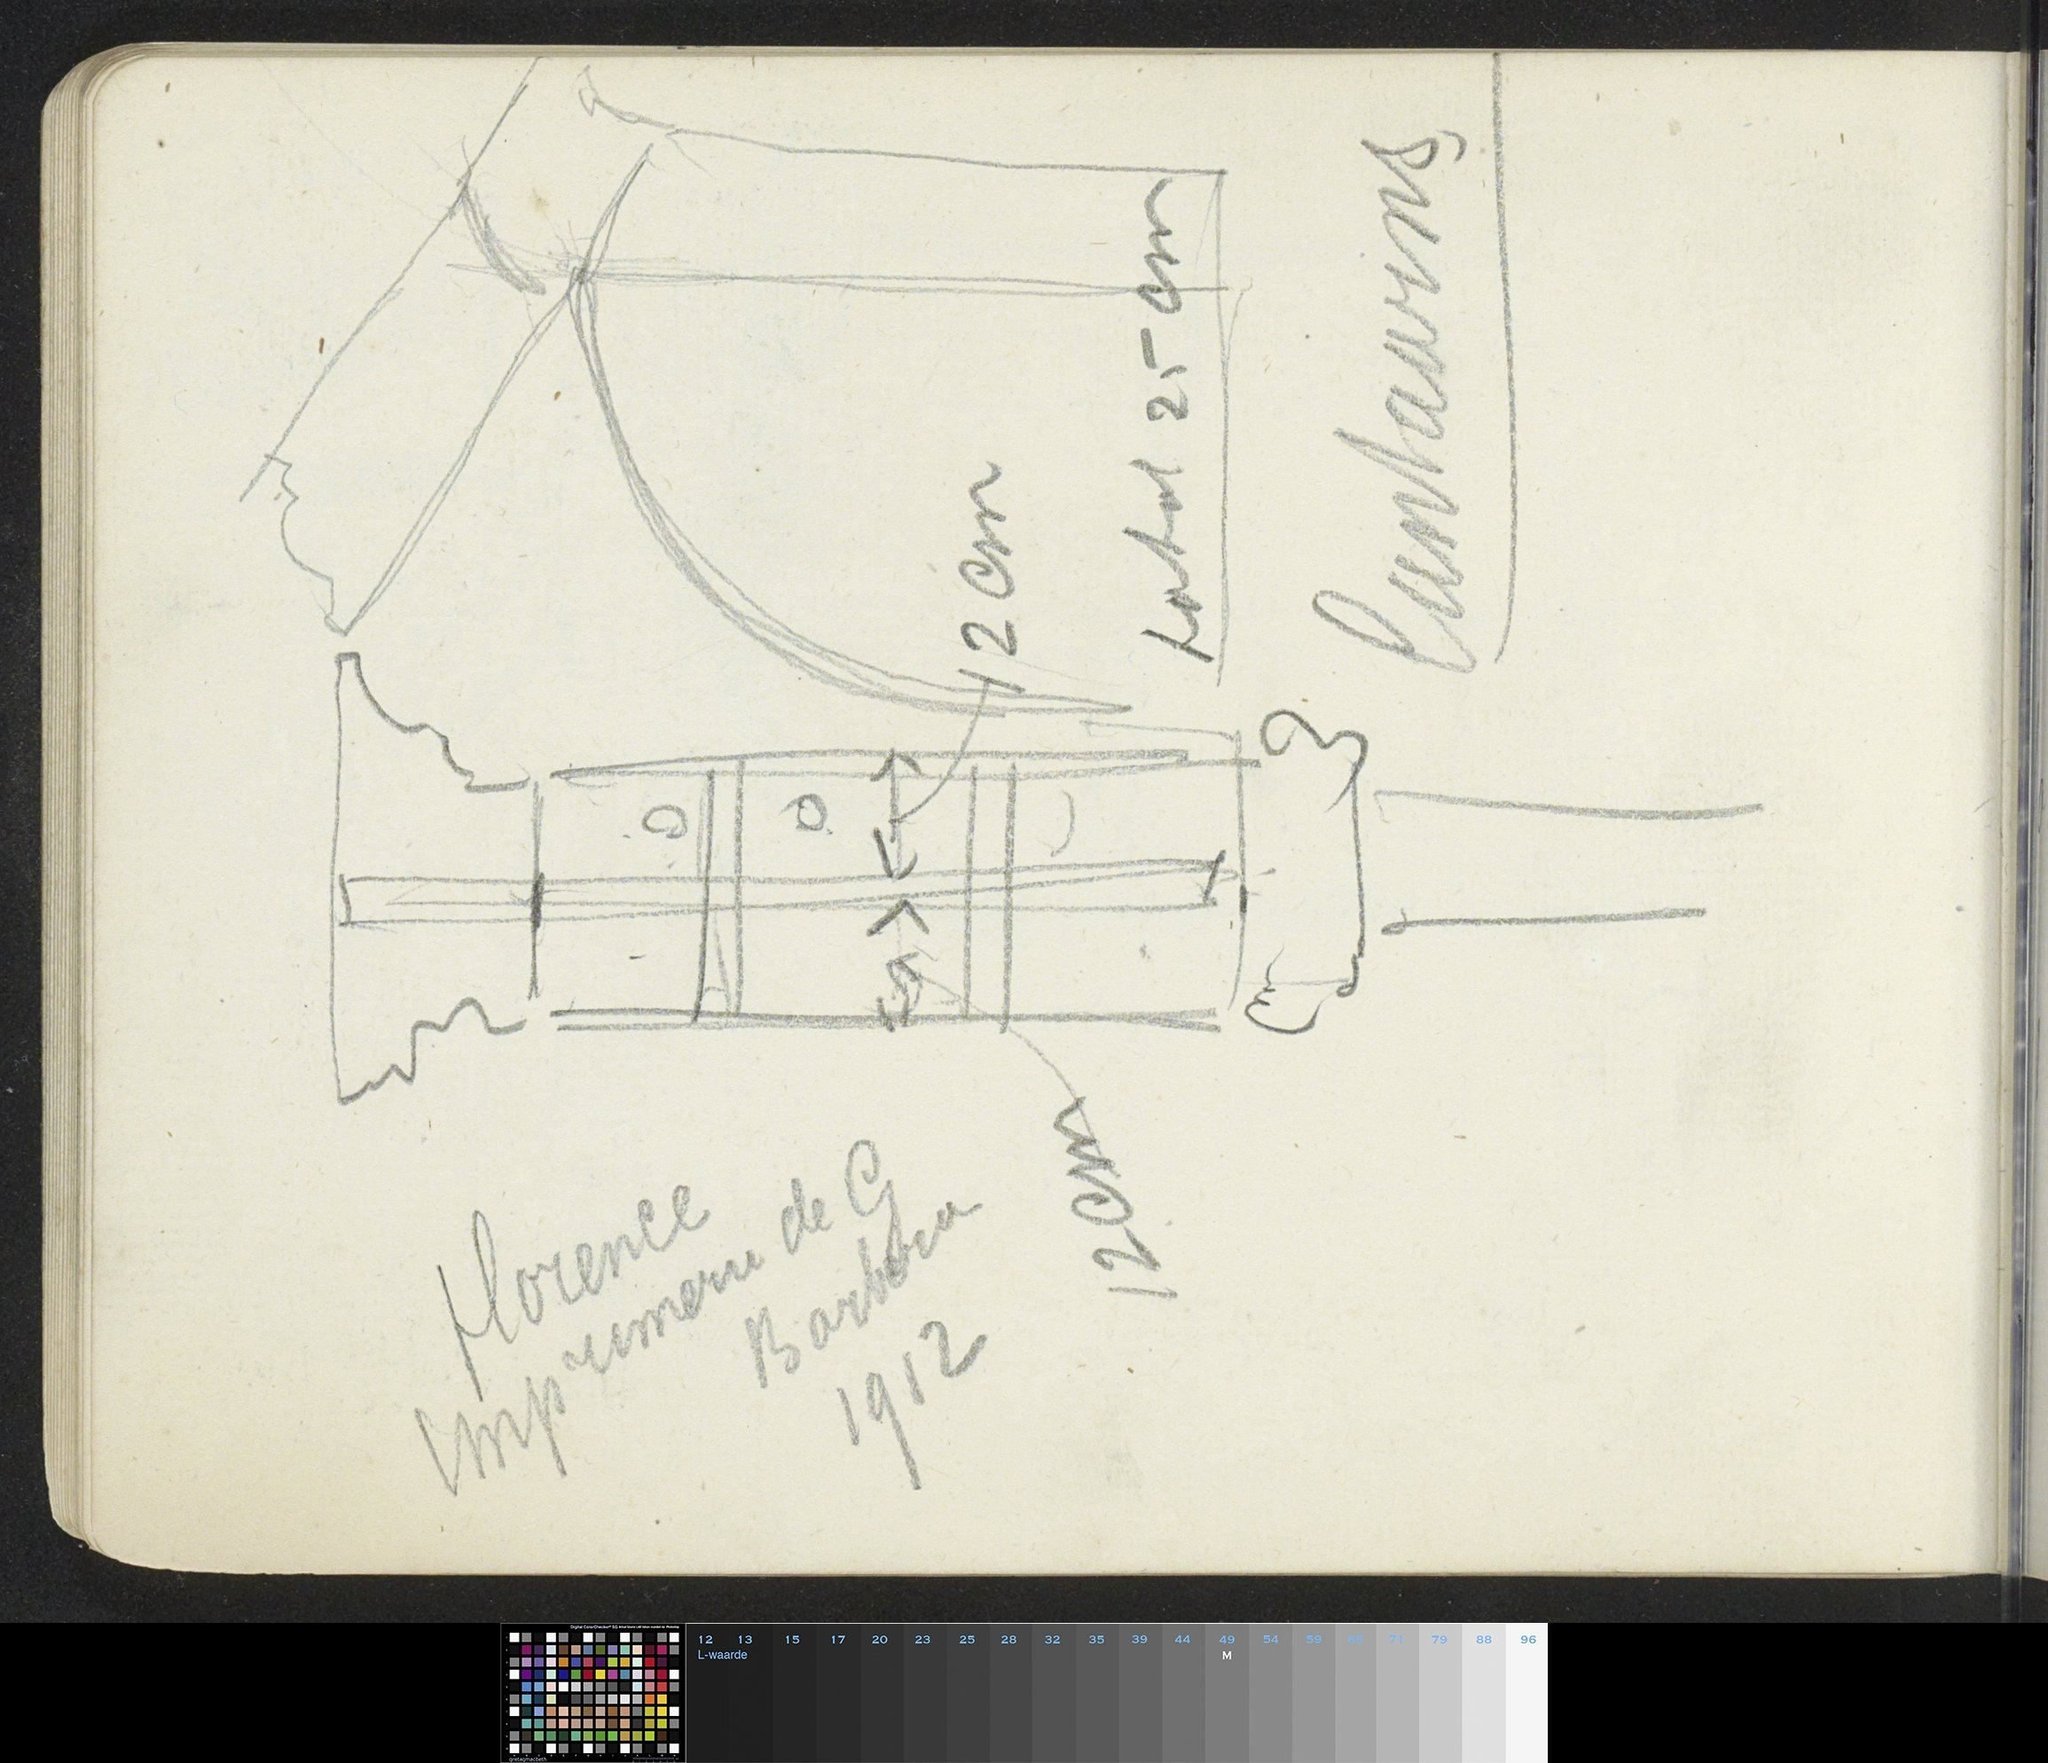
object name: sketchbook leaf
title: Ontwerp voor een lantaarn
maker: carel adolph lion cachet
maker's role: draughtsman, print maker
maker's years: 1864-1945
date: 1928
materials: paper, pencil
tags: lantern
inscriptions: annotation: ‘florence/ imprimerie de G/ Barbera/ 1912/ lantaarns’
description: Blad 15 verso uit een schetsboek met 24 bladen.